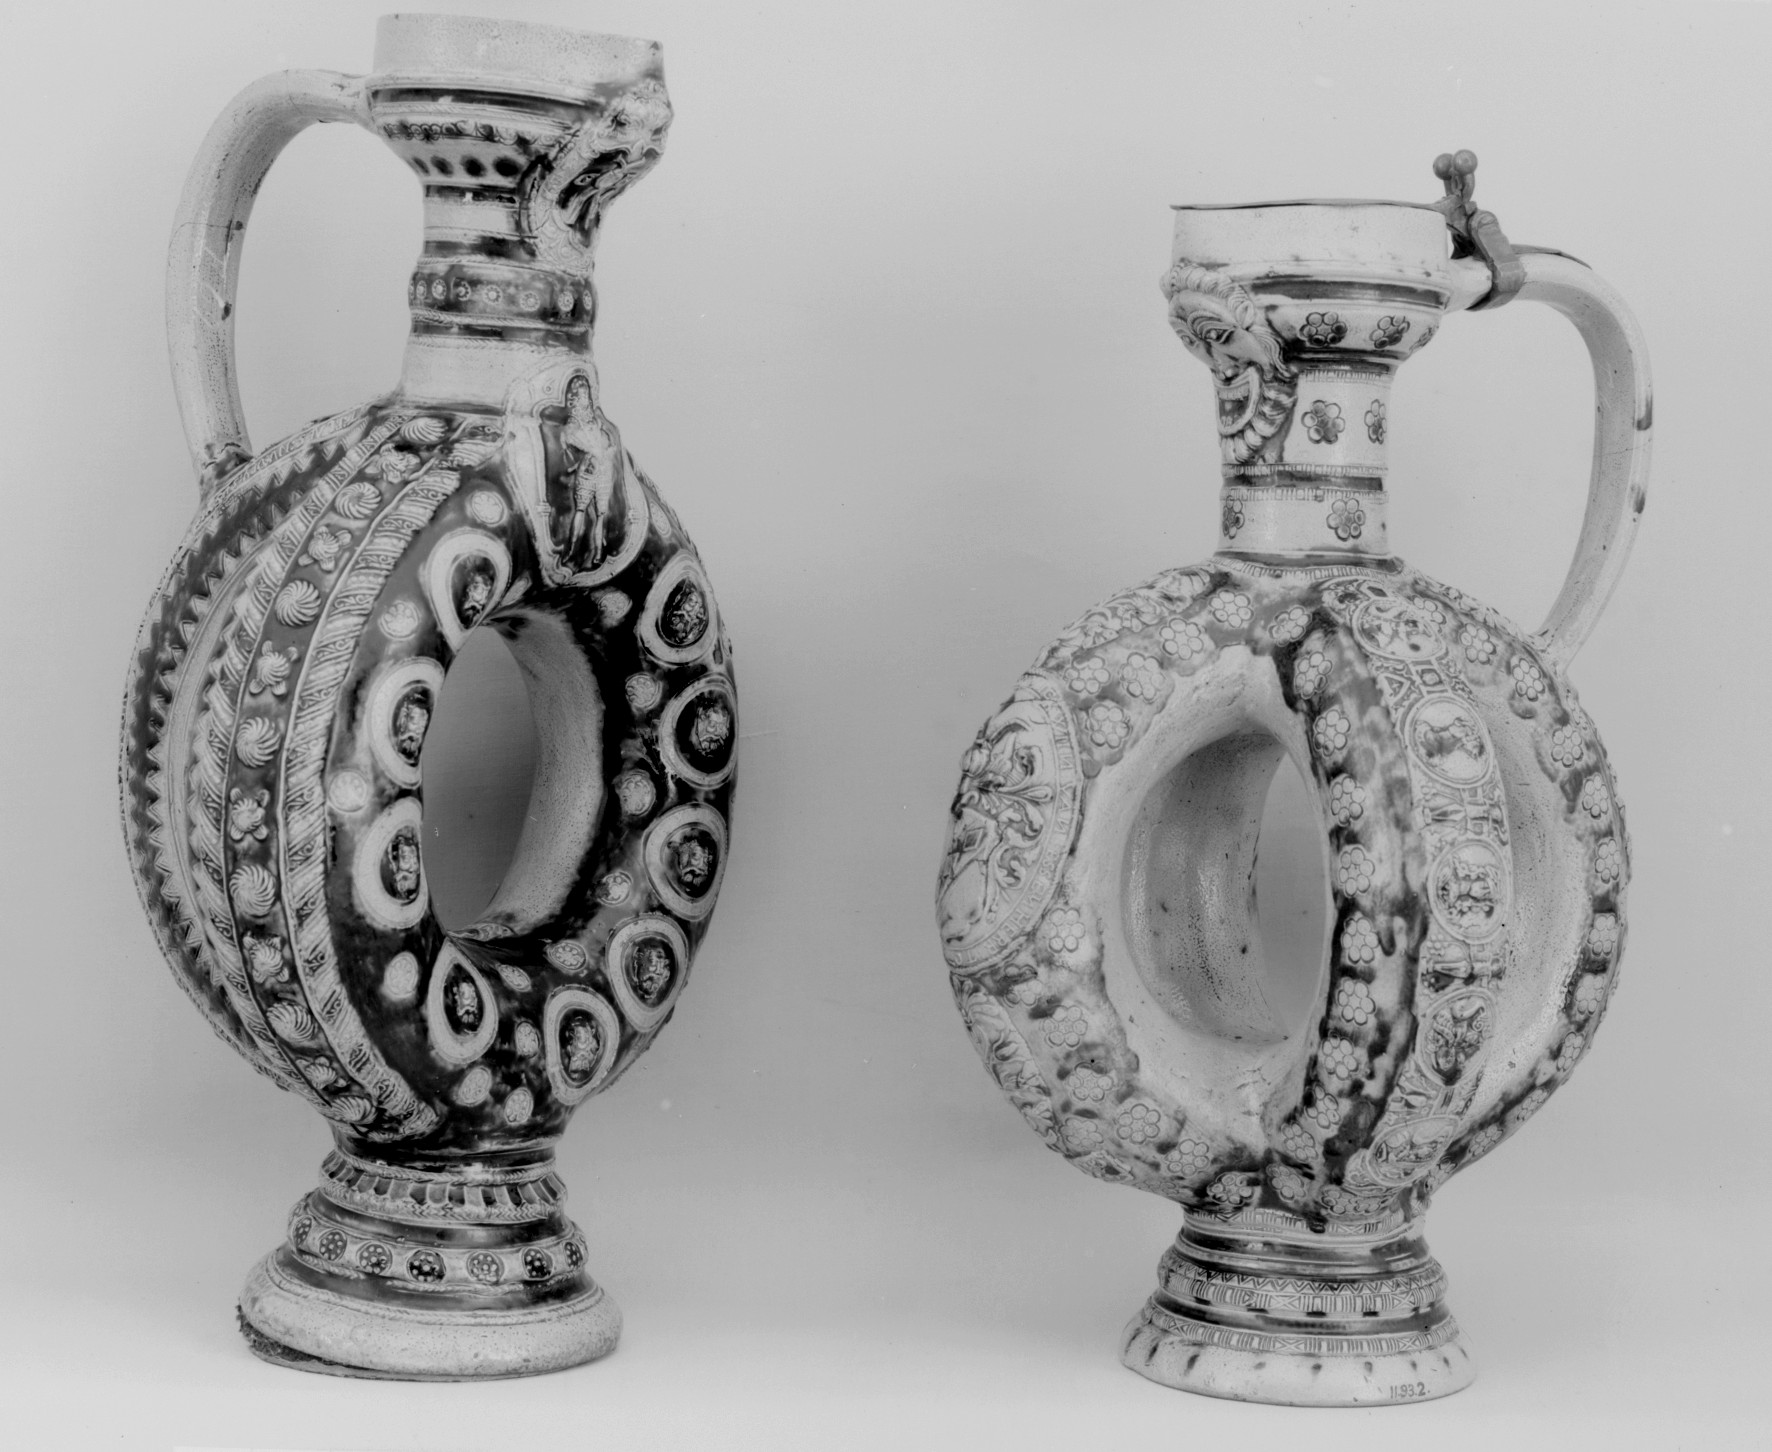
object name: jug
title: Annular jug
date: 1601-1700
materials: stoneware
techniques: salt glaze